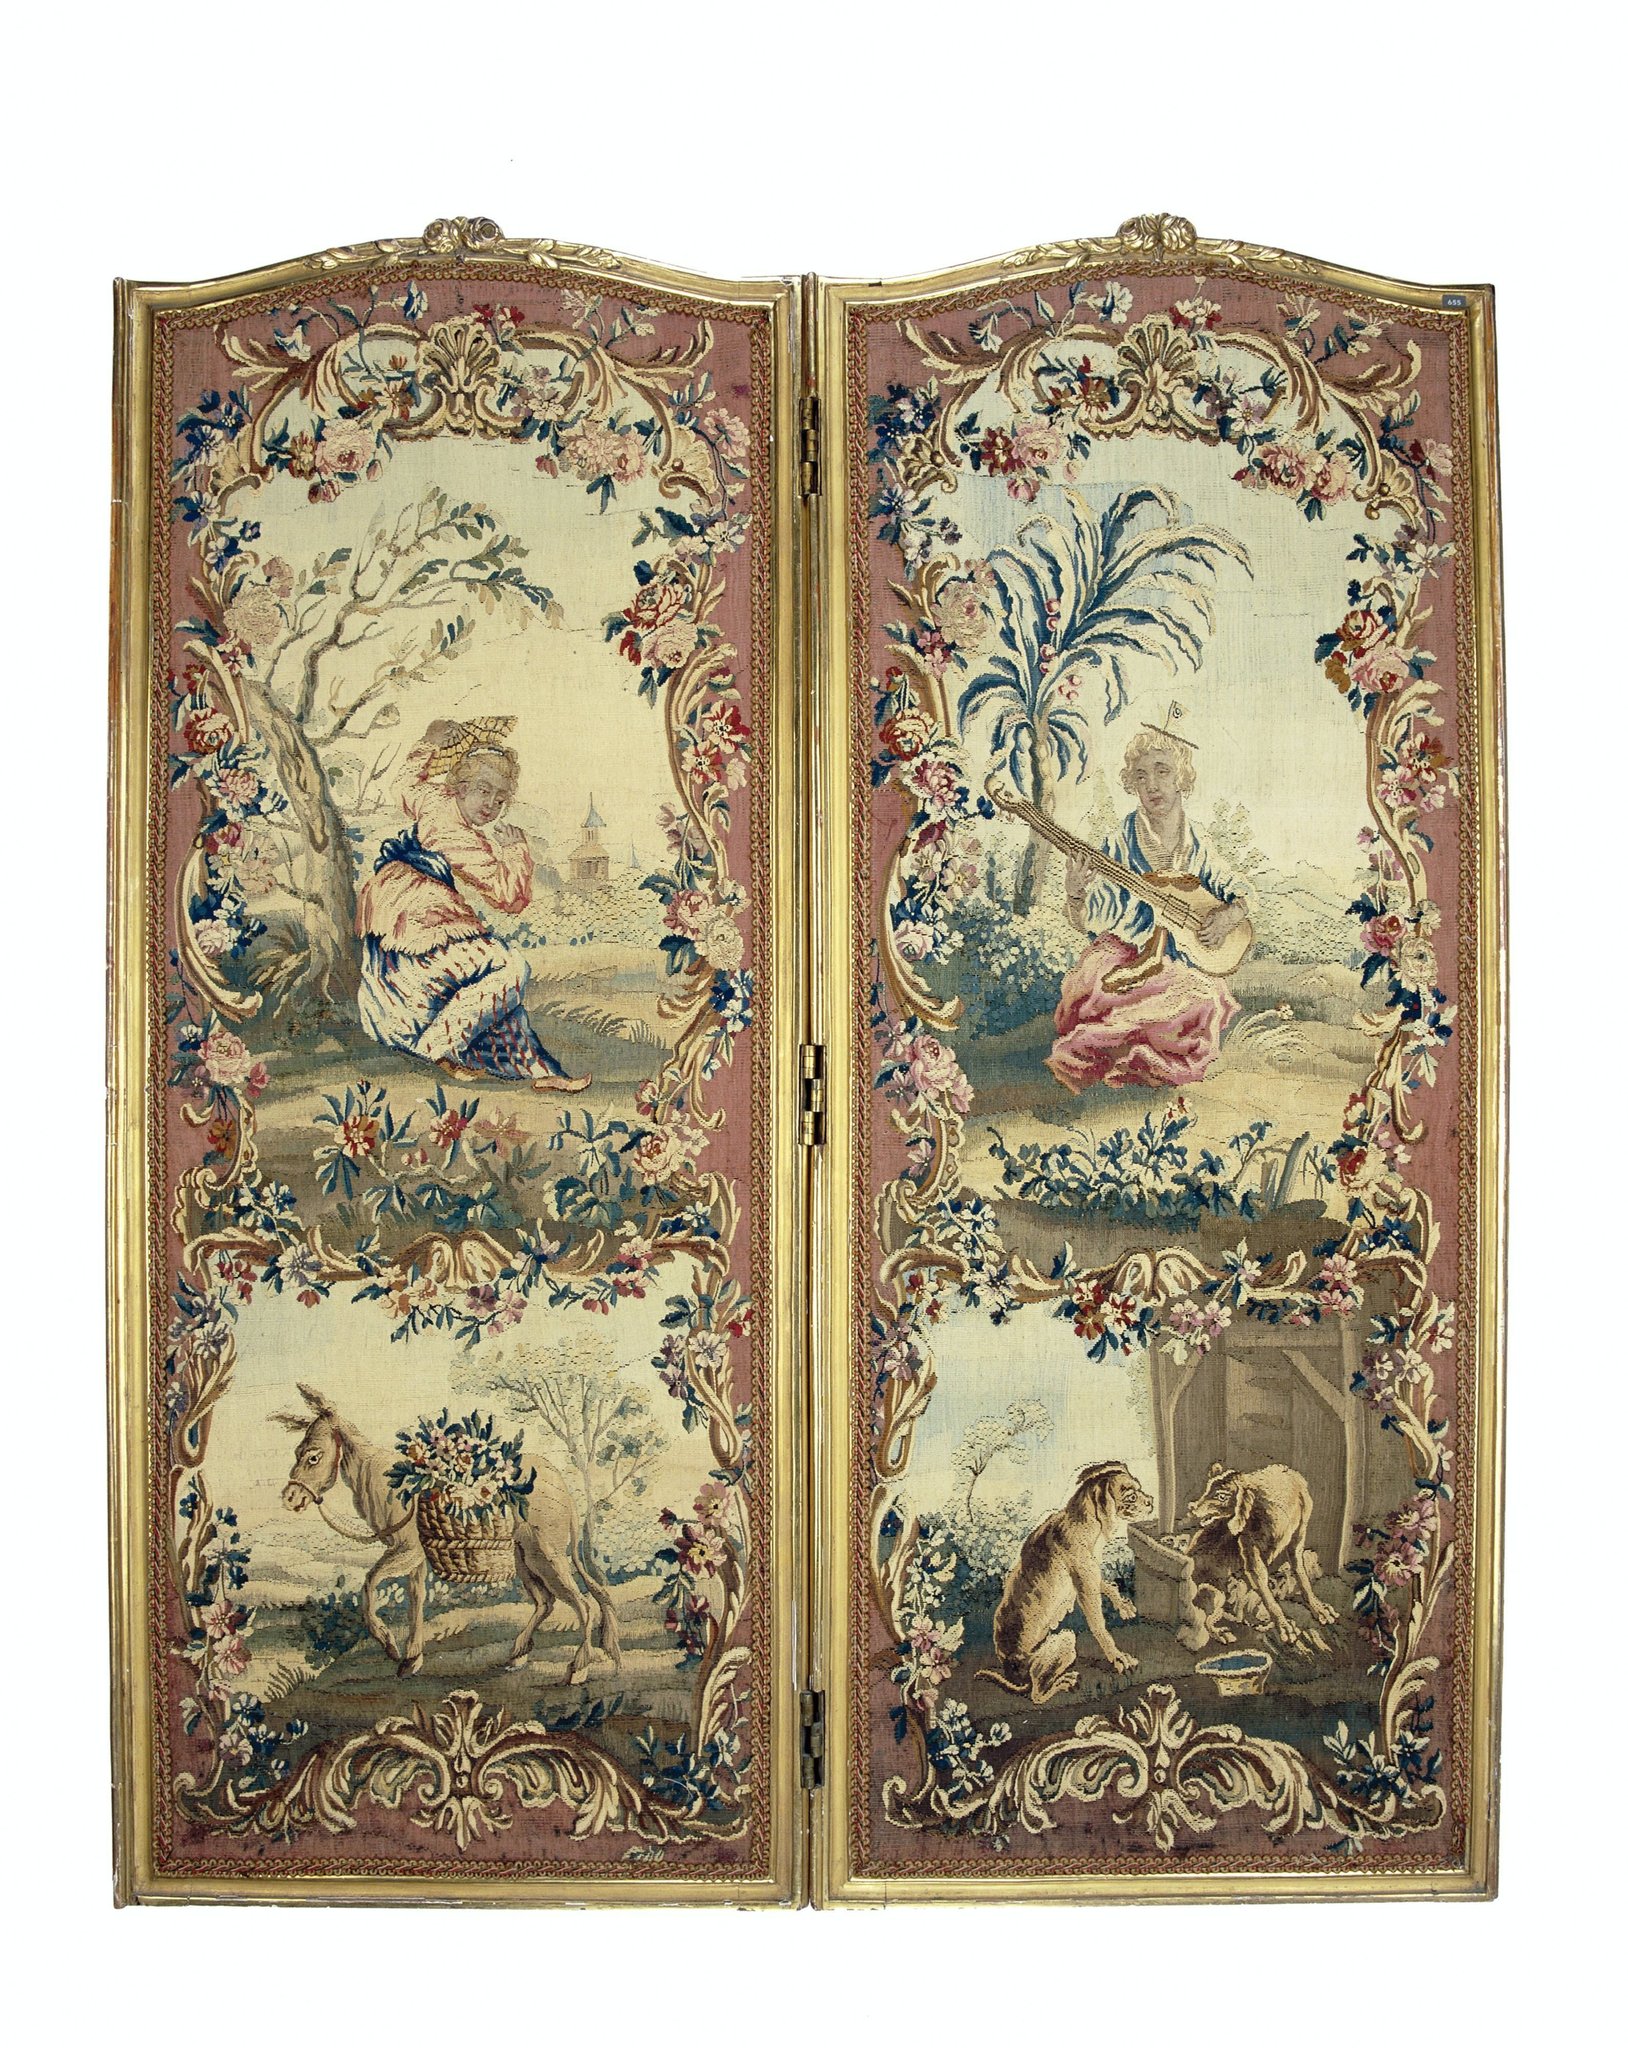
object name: screen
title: Kamerscherm, tweebladig, gestoffeerd met een weefsels met een oosterse danser en muzikant en dierenscènes uit de fabels van La Fontaine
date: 1745-1760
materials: wood, silk, wool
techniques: tapestry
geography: france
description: Tweebladig scherm van verguld beukenhout, bekleed met tapisserie de Beauvais. Ieder blad vertoont twee velden binnen een omraming met rocaille-motieven en bloemen. Het linkerblad heeft boven een dansend meisje en onder een ezel bepakt met een mand met bloemen. Het rechterblad vertoont boven een guitaar spelend meisje en onder twee honden.